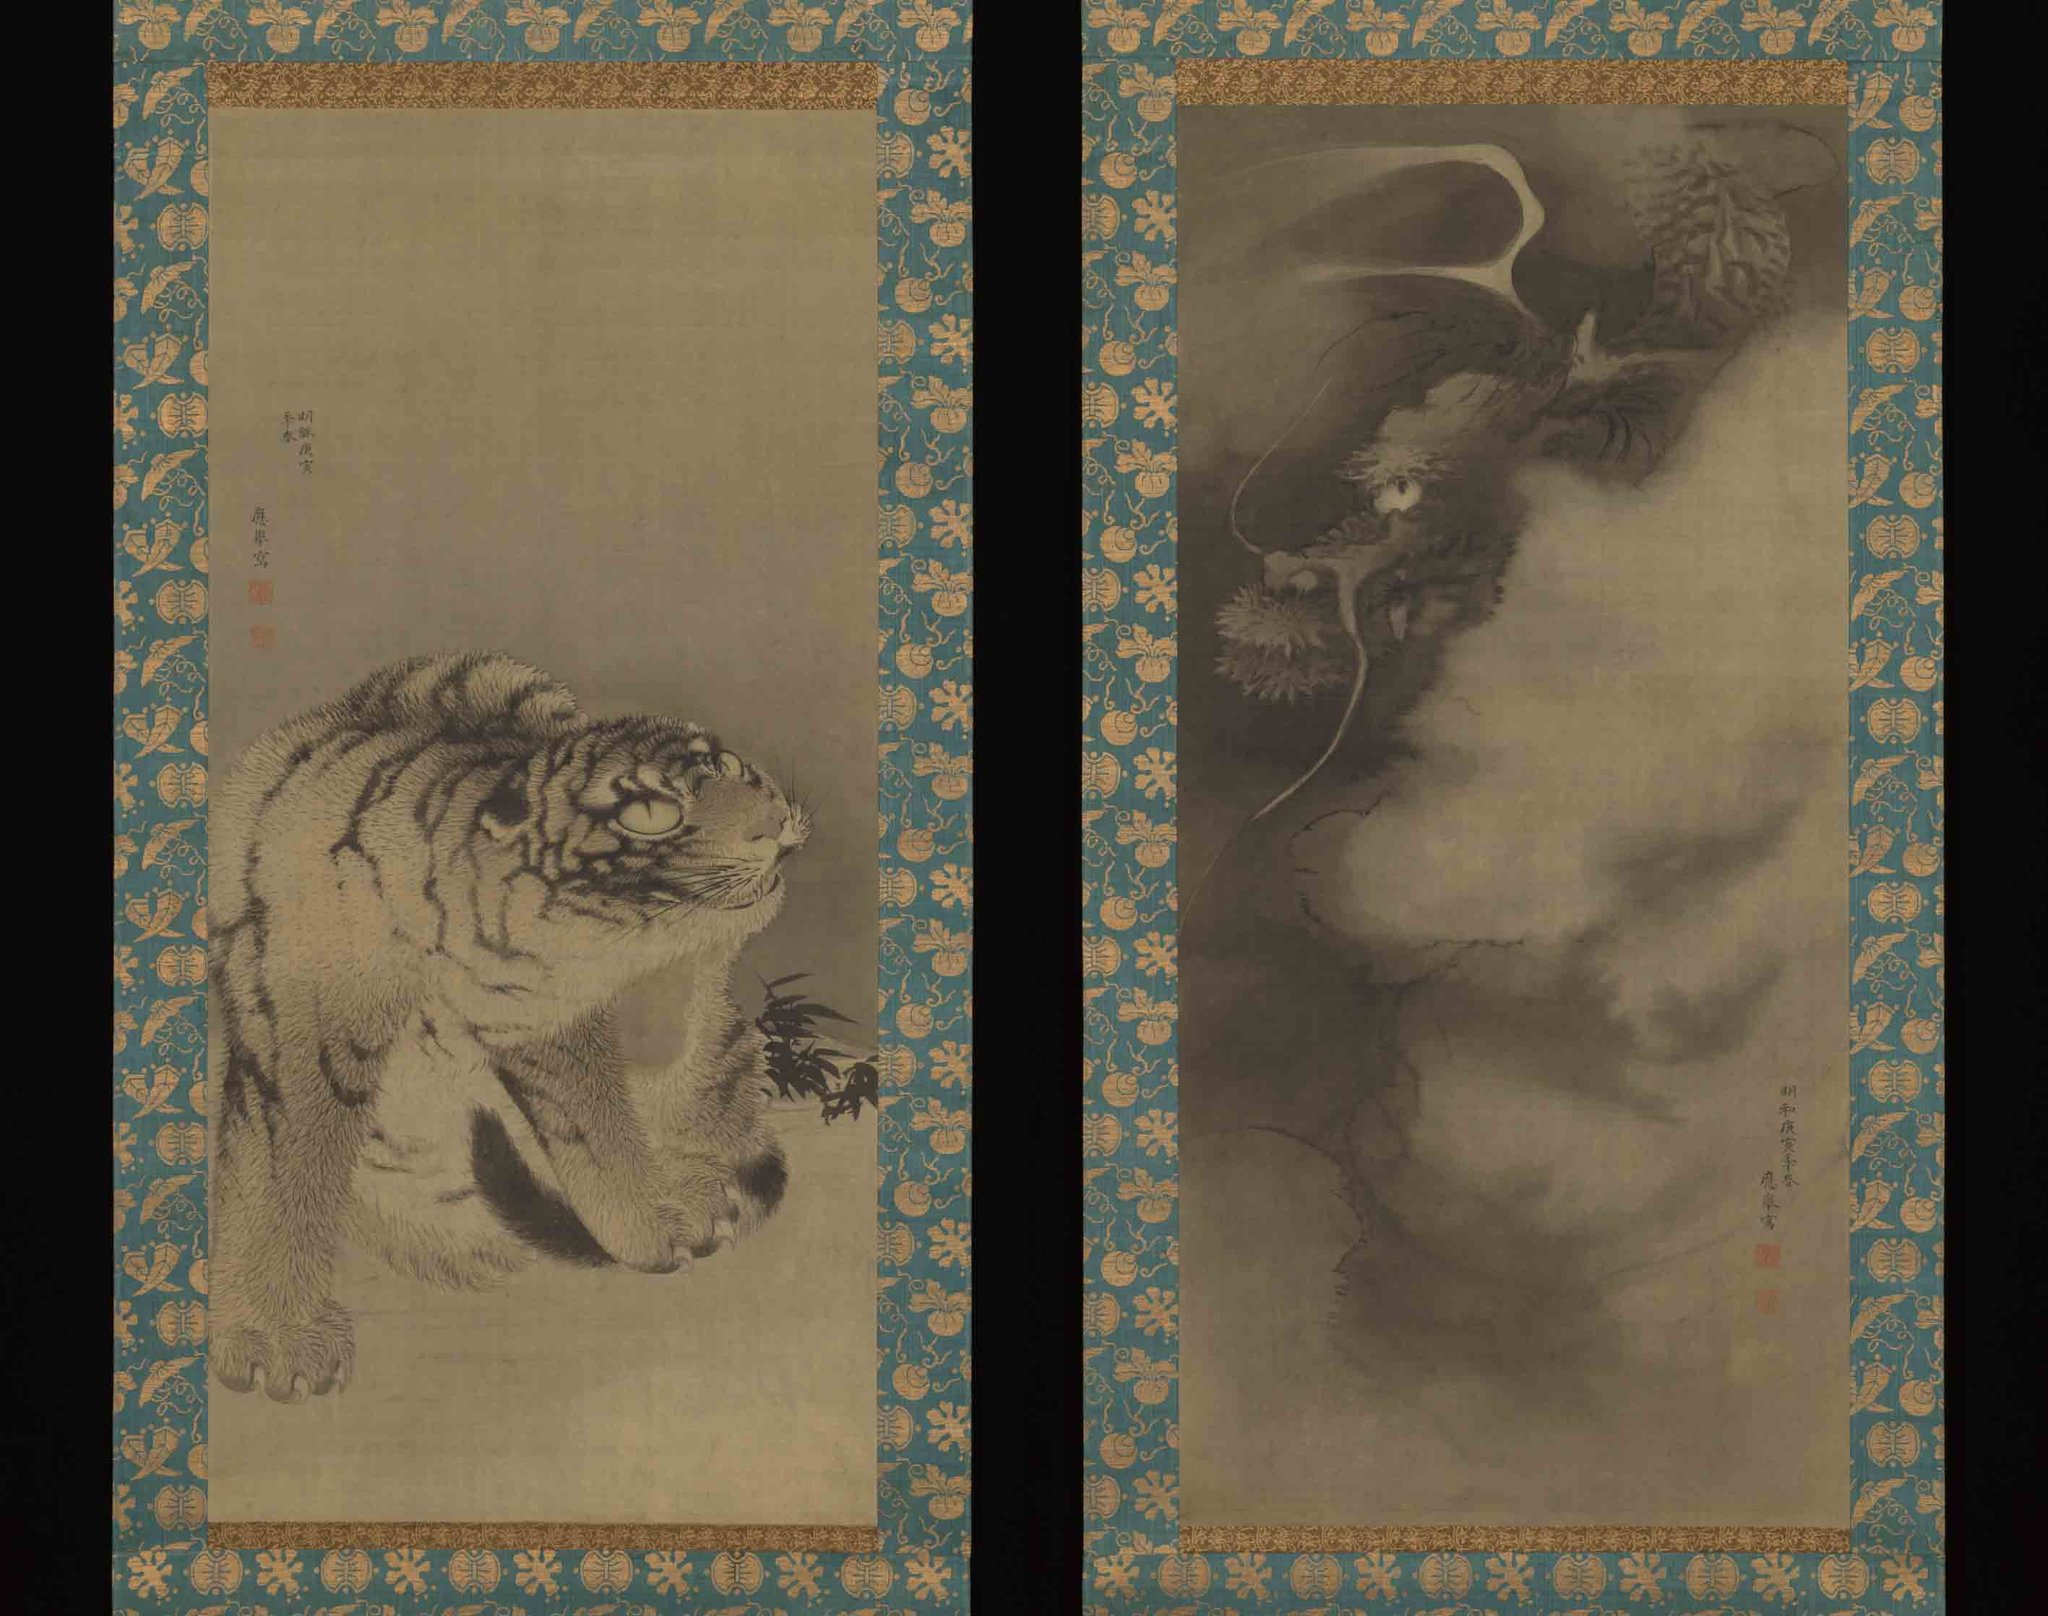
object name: hanging scroll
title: Dragon and Tiger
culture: japanese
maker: maruyama ōkyo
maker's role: artist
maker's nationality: japanese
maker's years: 1733-1795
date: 1770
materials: ink, silk